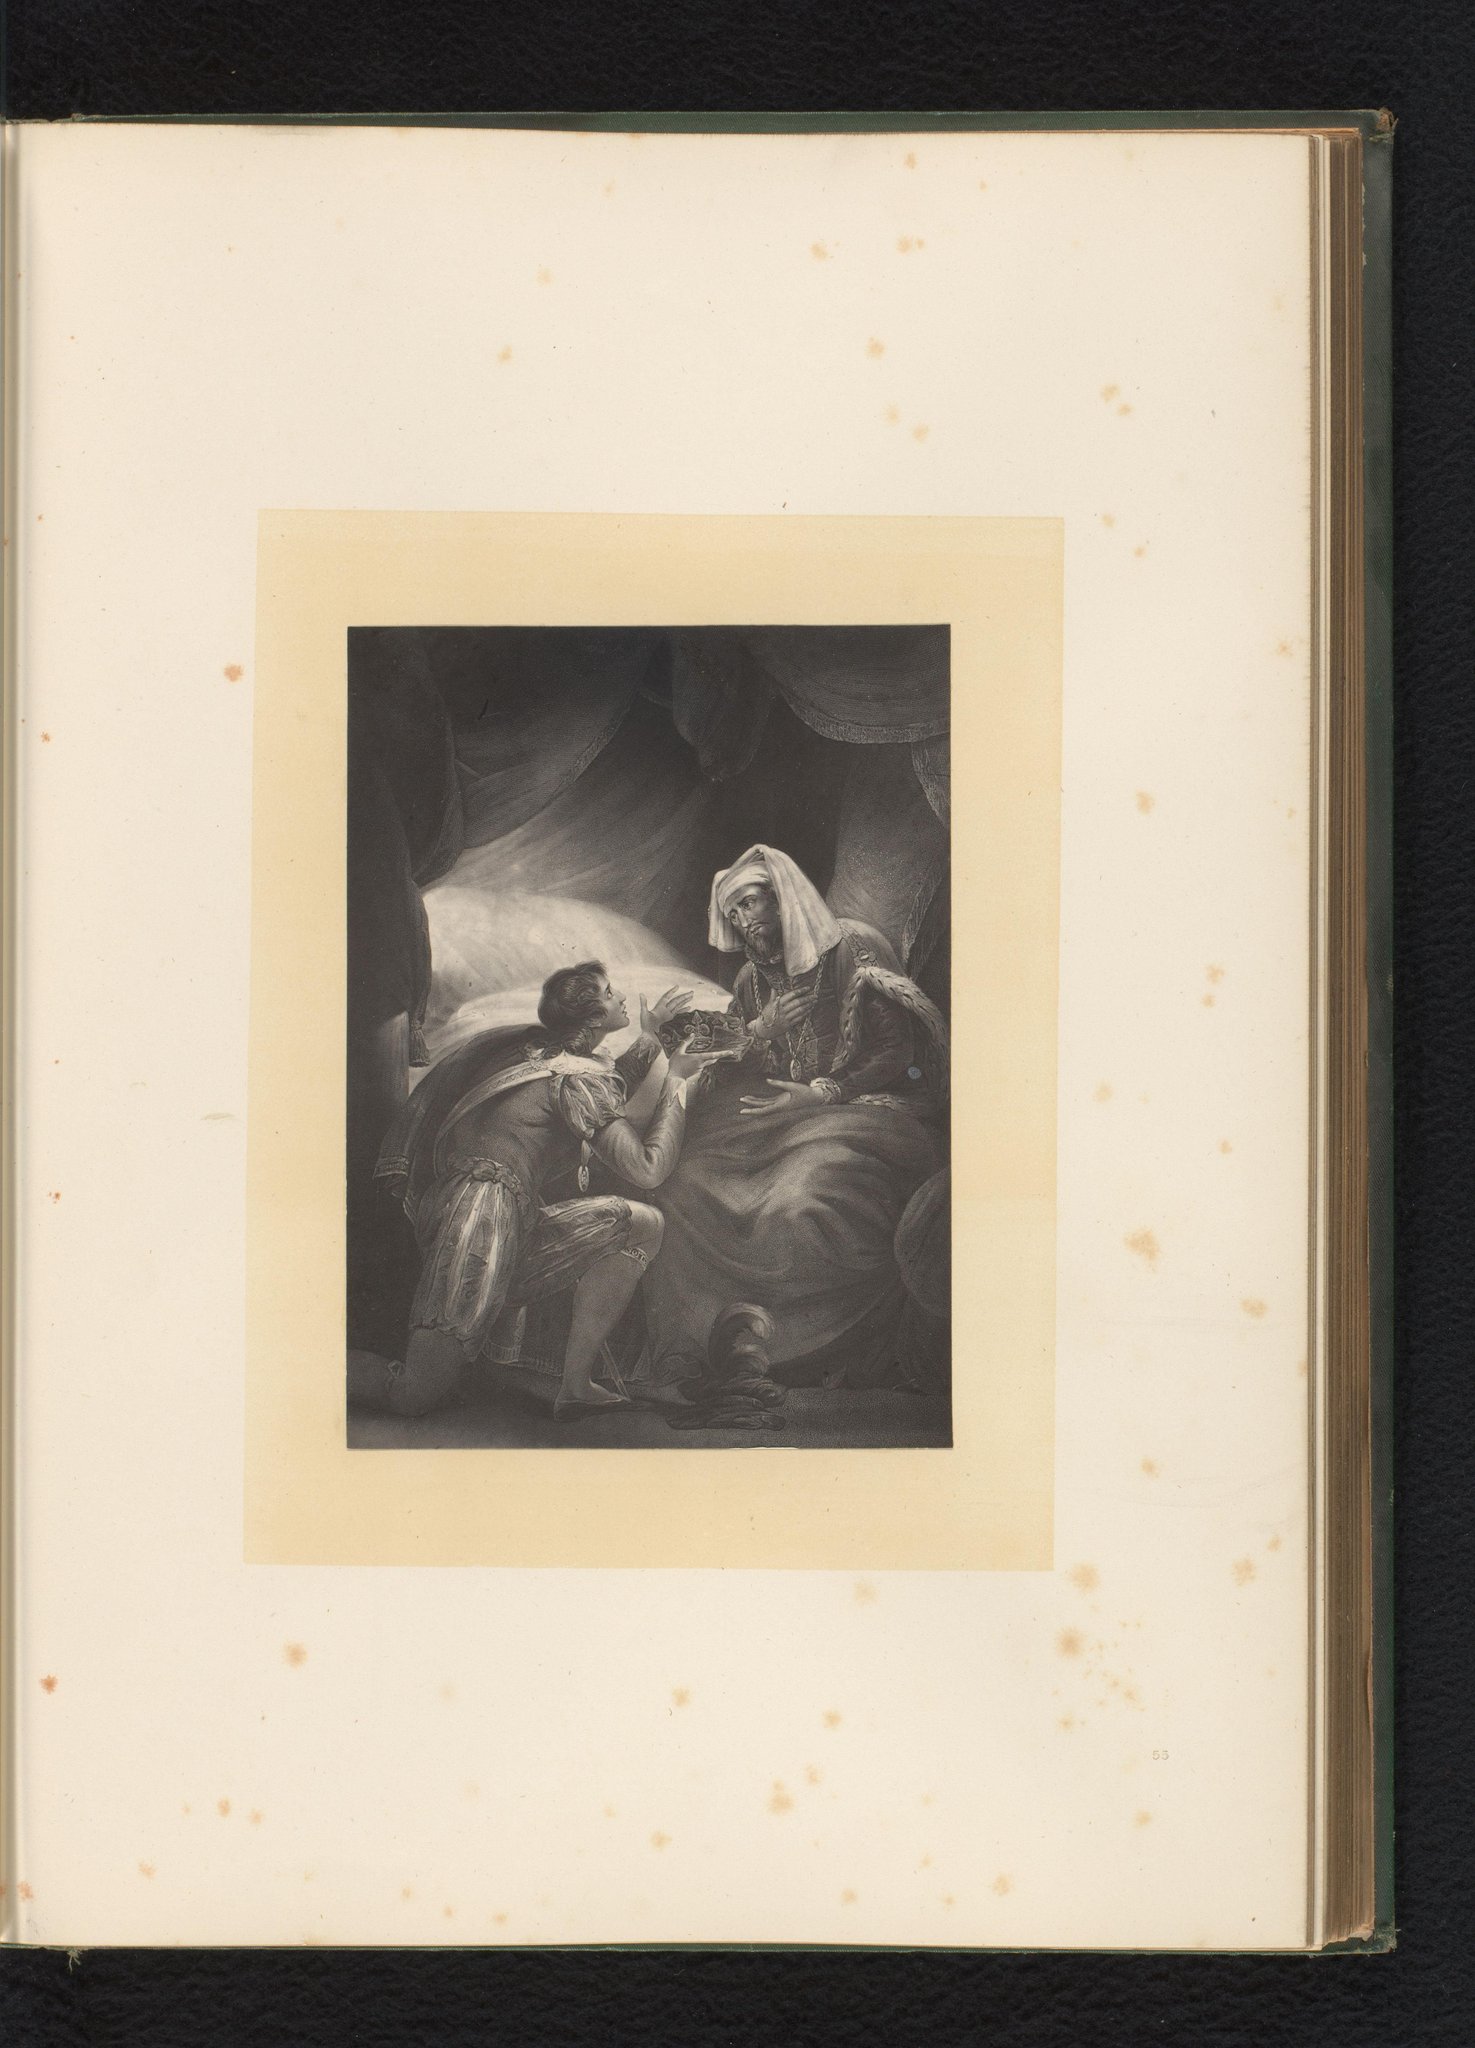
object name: page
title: Reproductie van een gravure naar een schilderij van een scène uit King Henry the Fourth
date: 1874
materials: paper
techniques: woodburytype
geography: london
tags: theatre, theatrical performance